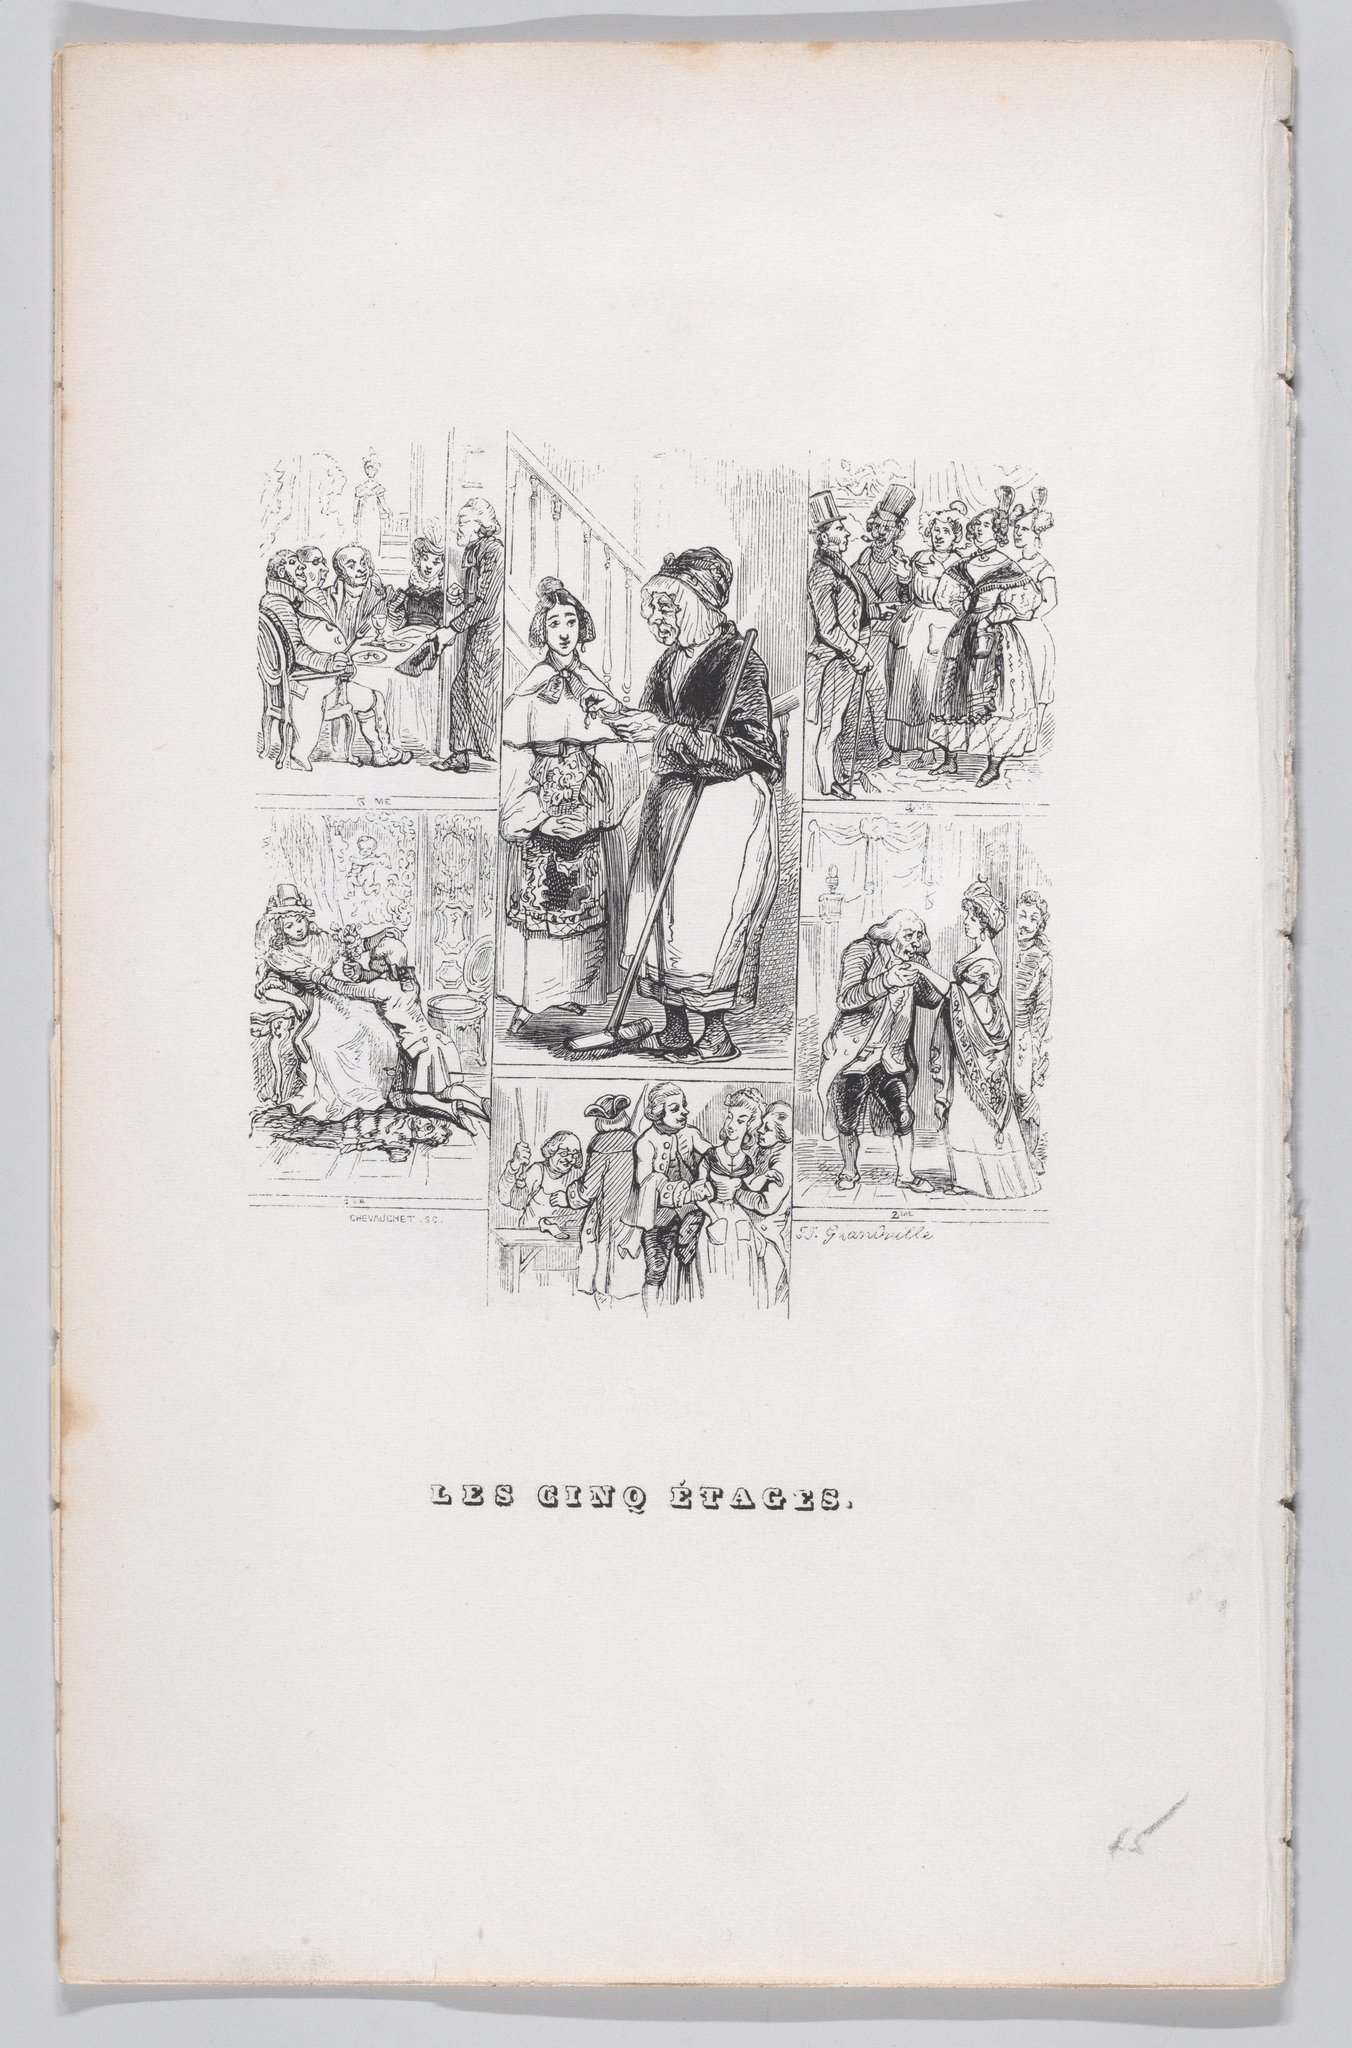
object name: print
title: The Five Stages, from "The Complete Works of Béranger"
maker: j. j. grandville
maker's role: illustrator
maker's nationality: french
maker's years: 1803-1847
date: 1836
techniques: engraving